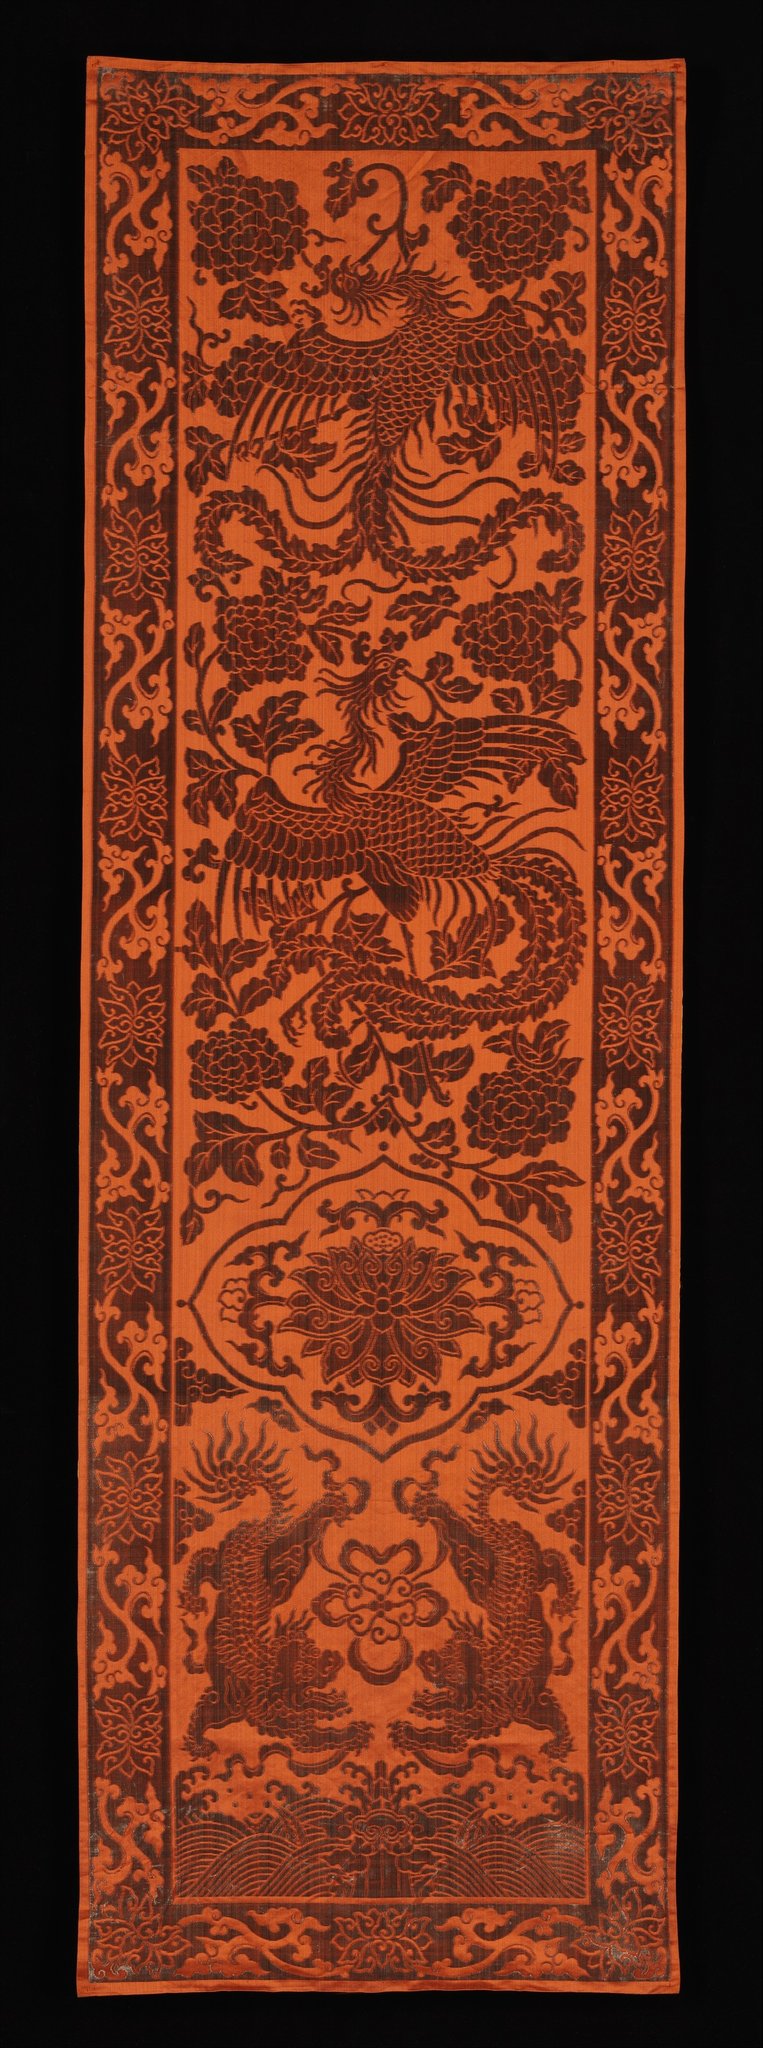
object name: chair strip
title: Chair strip with Lions and Phoenixes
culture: chinese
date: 1701-1800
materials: silk, velvet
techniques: cutting, voiding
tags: birds,mythical creatures,flowers,leaves